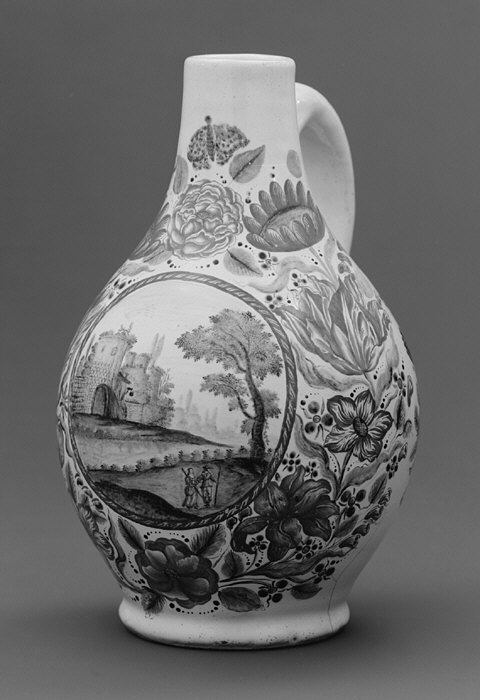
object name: tankard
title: Tankard (Krug)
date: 1667-1700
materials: faience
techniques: glazing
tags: human figures,castles,flowers,trees